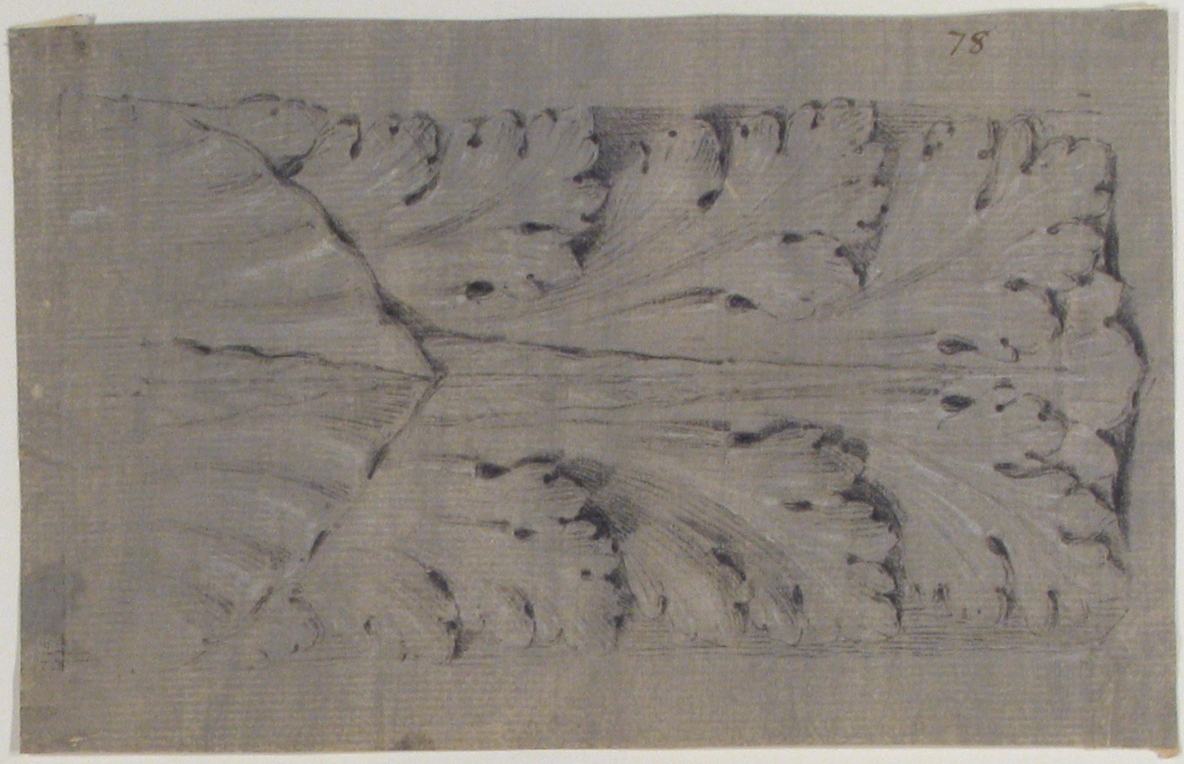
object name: drawing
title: Design for a Leaf Motif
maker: anonymous, french, 19th century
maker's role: artist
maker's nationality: french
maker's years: 1800-1900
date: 1825-1850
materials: chalk, graphite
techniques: heightening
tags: leaves